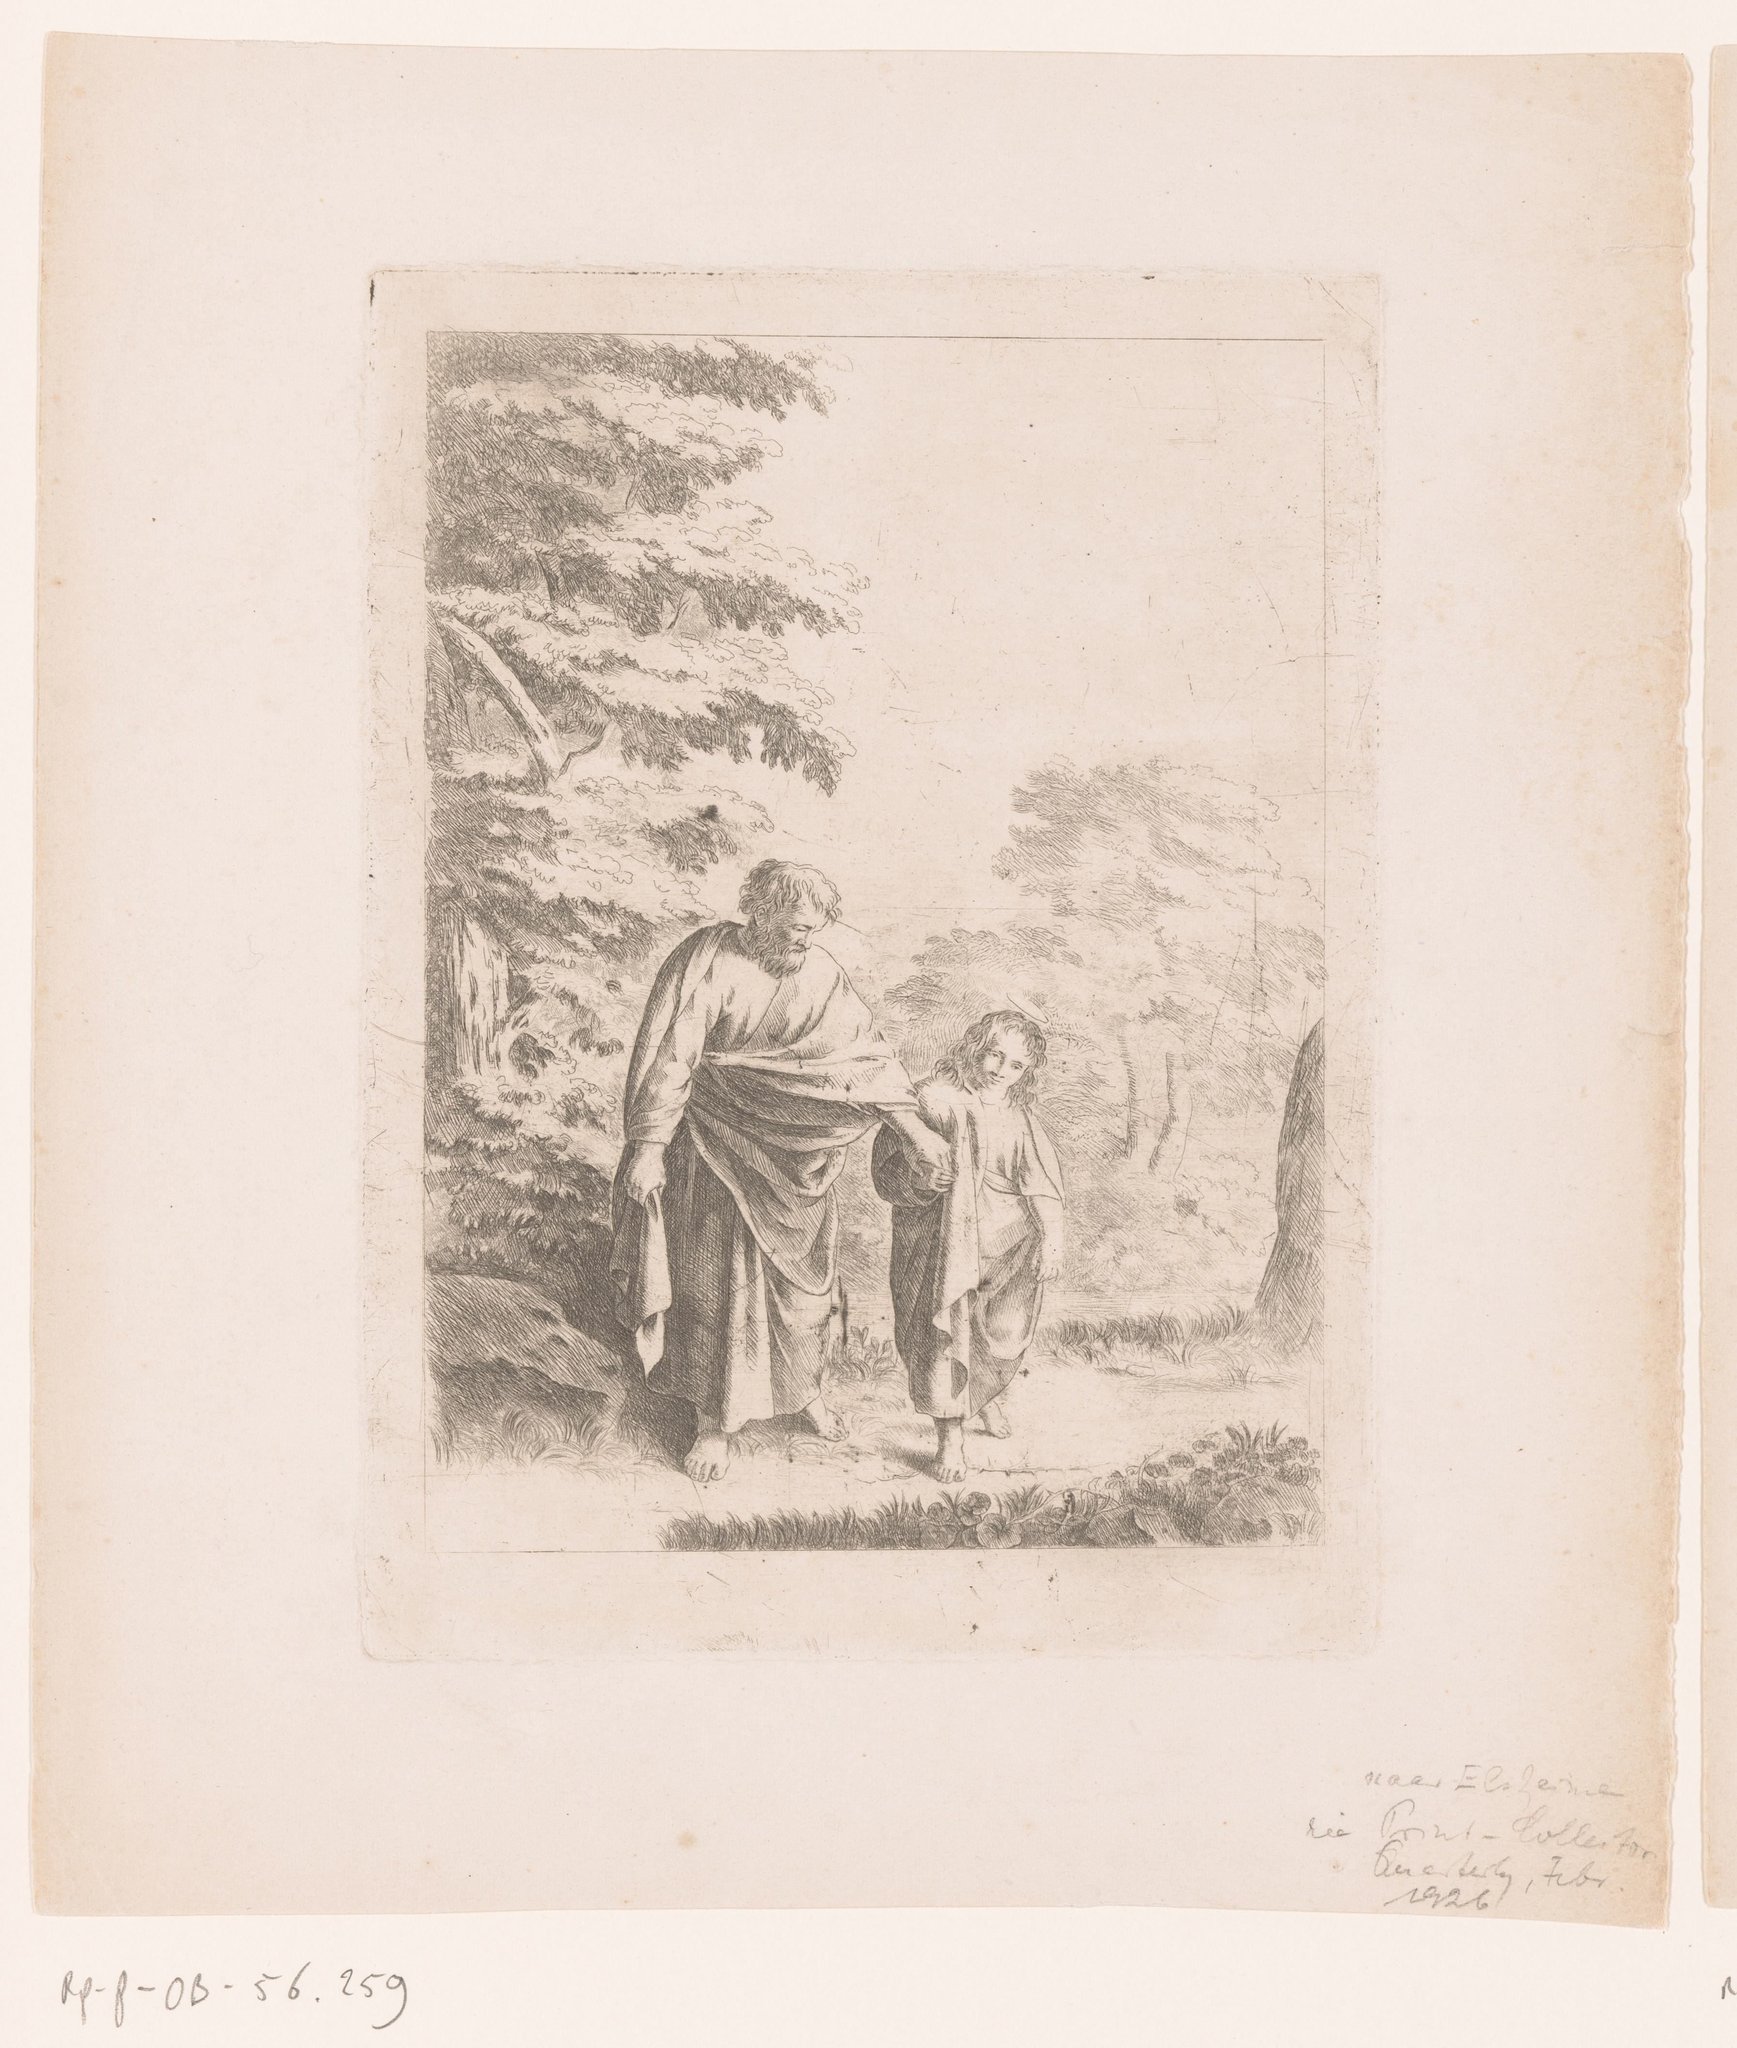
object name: print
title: Jozef van Nazareth met Christus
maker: Anonymous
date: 1588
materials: paper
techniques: drypoint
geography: germany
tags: the foster-father of christ, joseph of nazareth, husband of mary; possible attributes: flowering rod or wand, lily, carpenter's tools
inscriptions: collector's mark: Lugt 2228